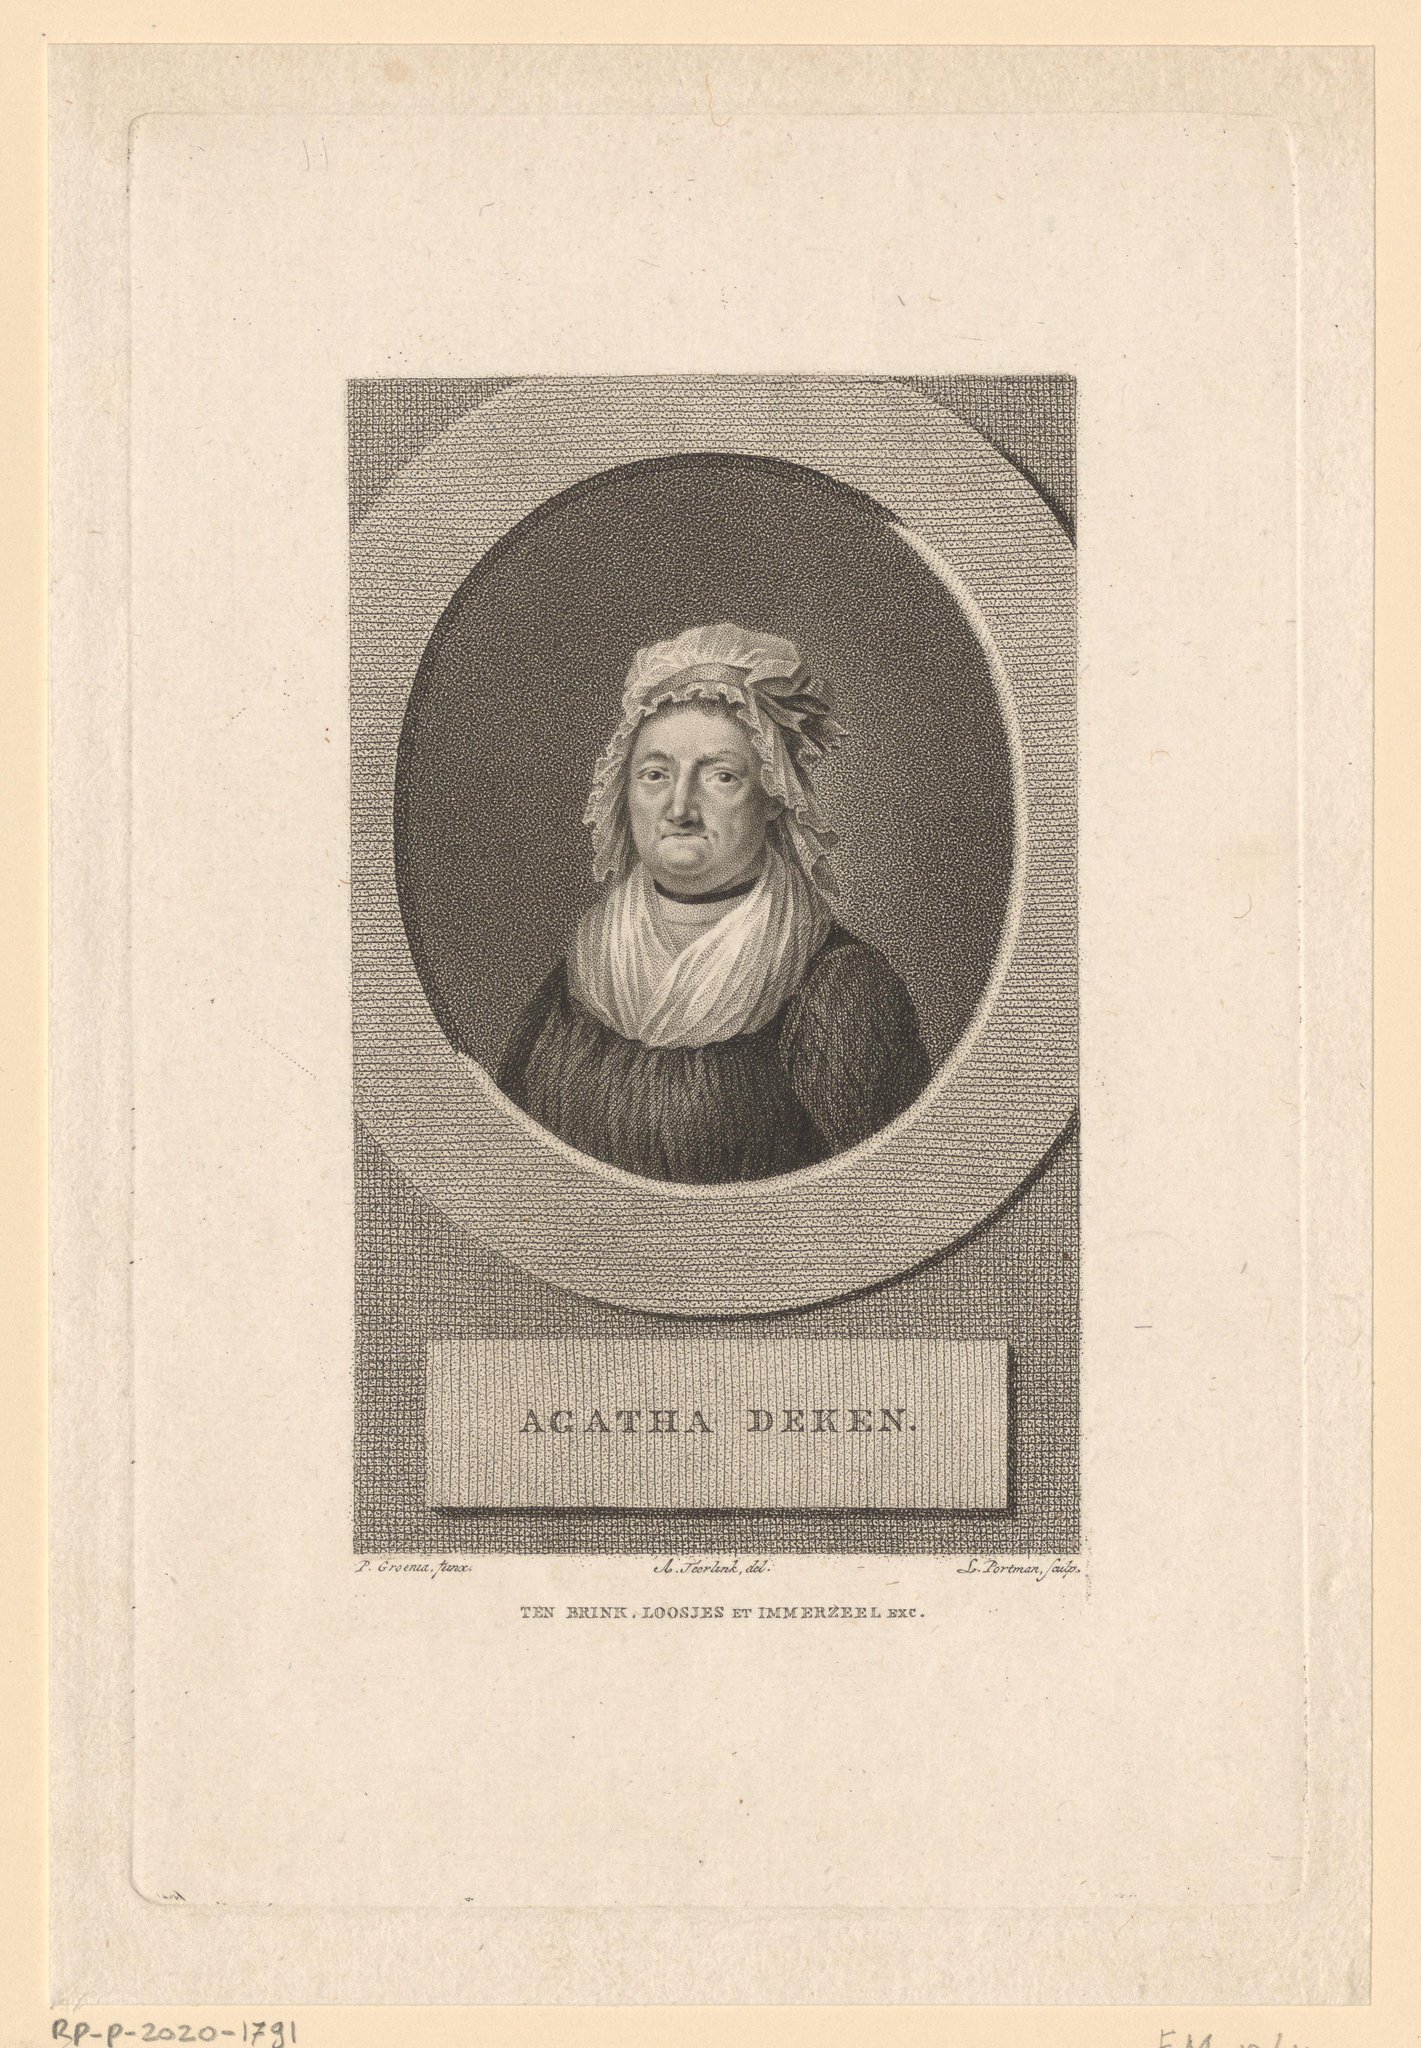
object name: print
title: Portret van Agatha Deken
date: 1805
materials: paper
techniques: etching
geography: haarlem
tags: the hague, agatha deken, historical persons - bb - woman, historical persons, portrait of a writer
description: Deze prent en de eerdere staten van deze prent zijn in 1905 ter herinnering samen met het portret van Elisabeth Bekker uitgegeven in een omslag getiteld: Portraiten van Elizabeth Wolff geb. Dekker, en Agatha Deken (...).